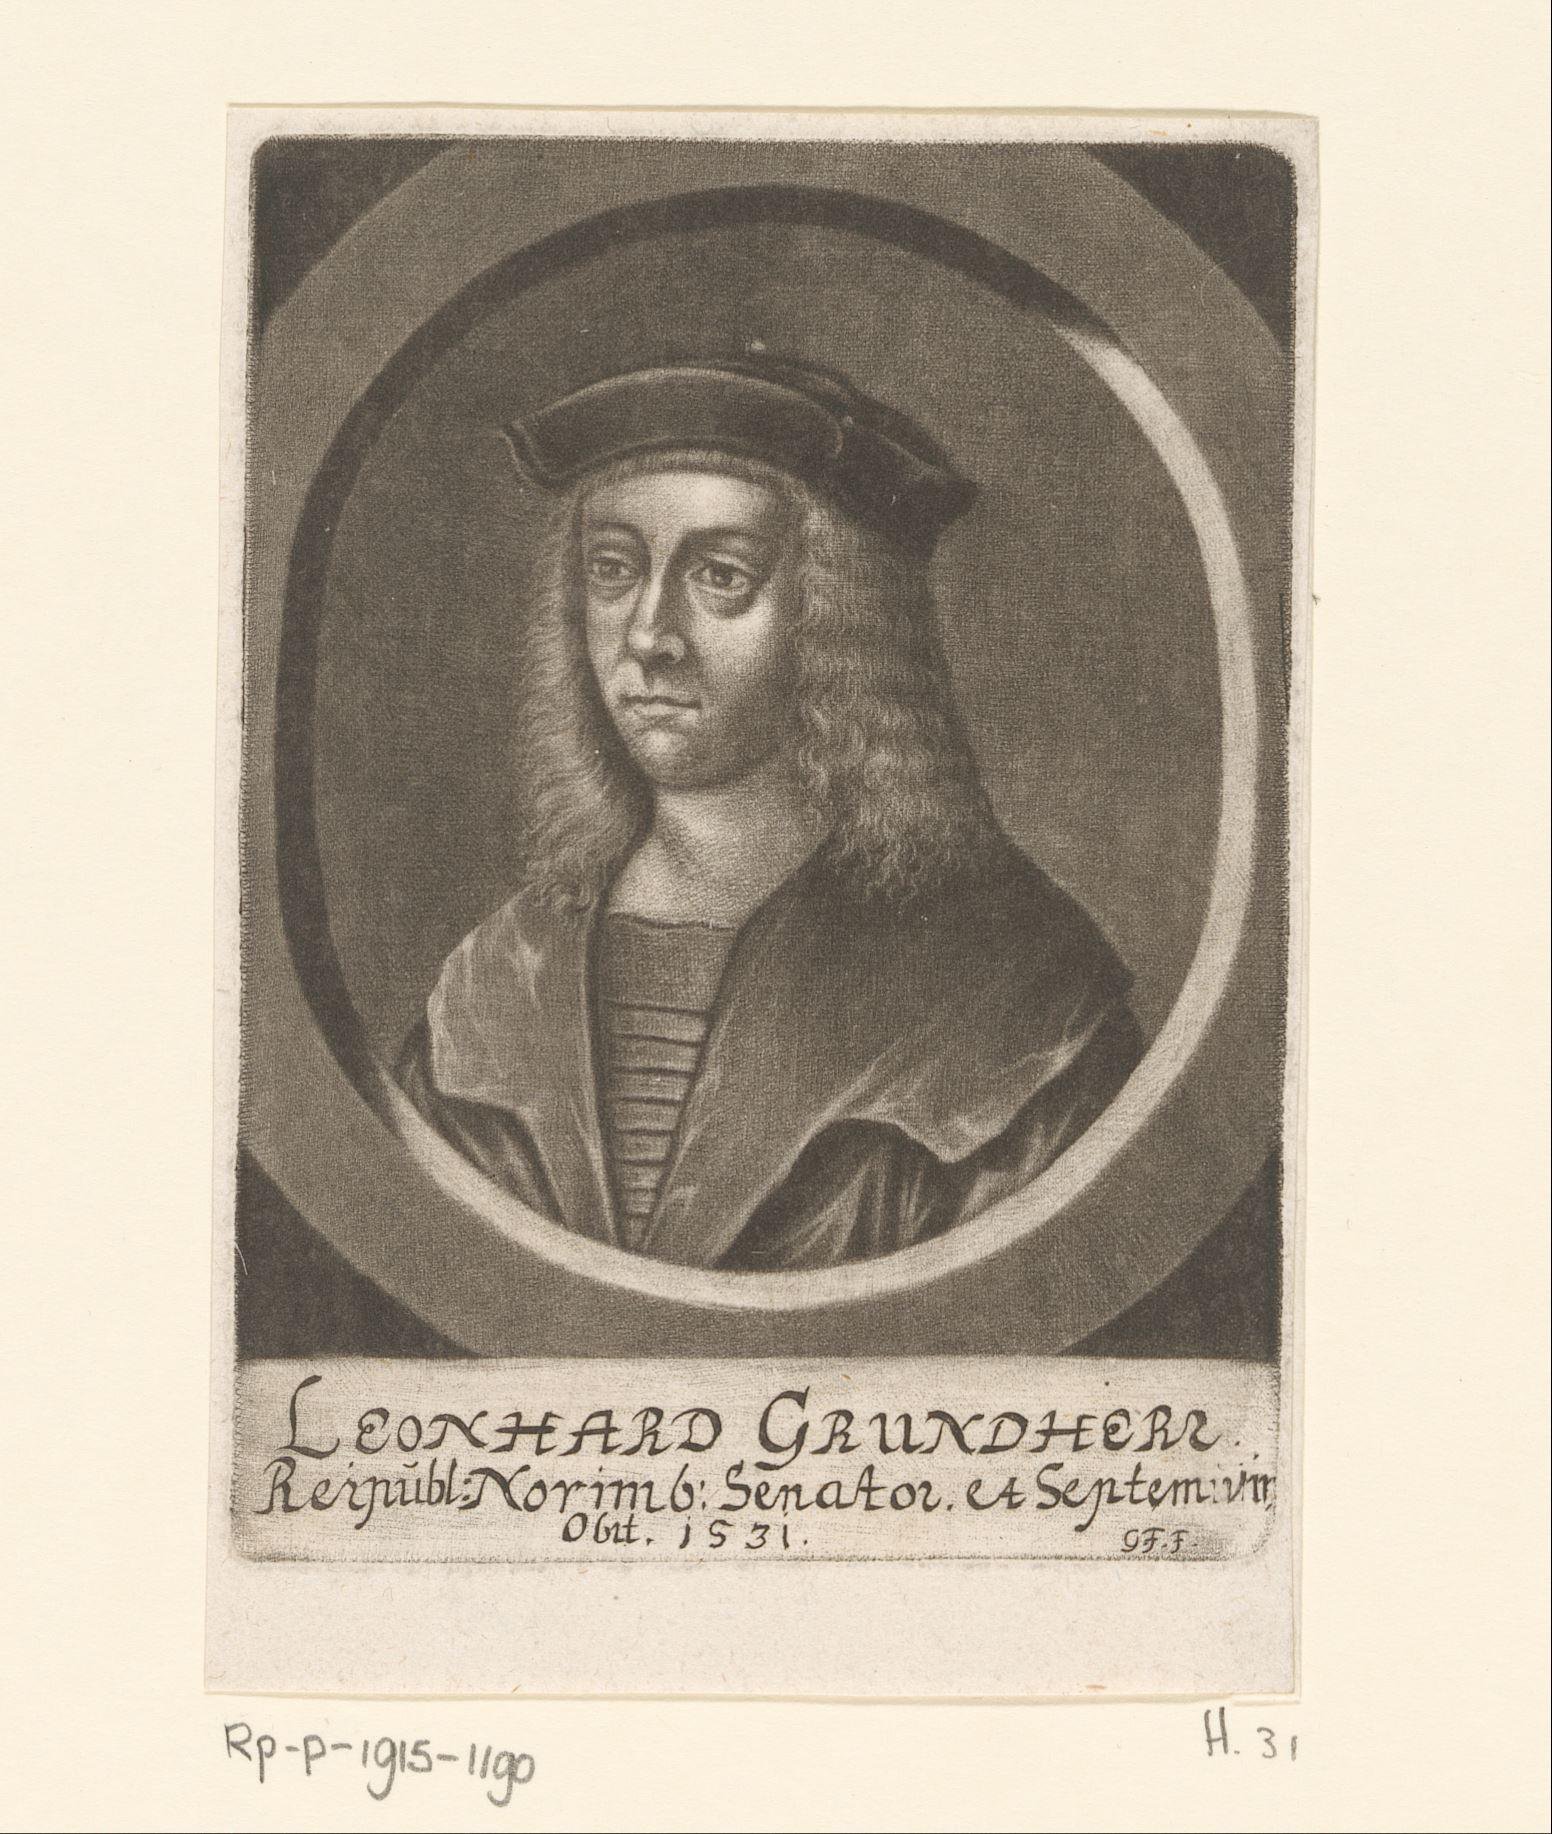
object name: print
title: Portret van Leonhard Grundherr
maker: georg fennitzer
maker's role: print maker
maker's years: 1646-1722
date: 1656-1722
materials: paper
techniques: mezzotint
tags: historical persons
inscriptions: collector's mark: Lugt 2228